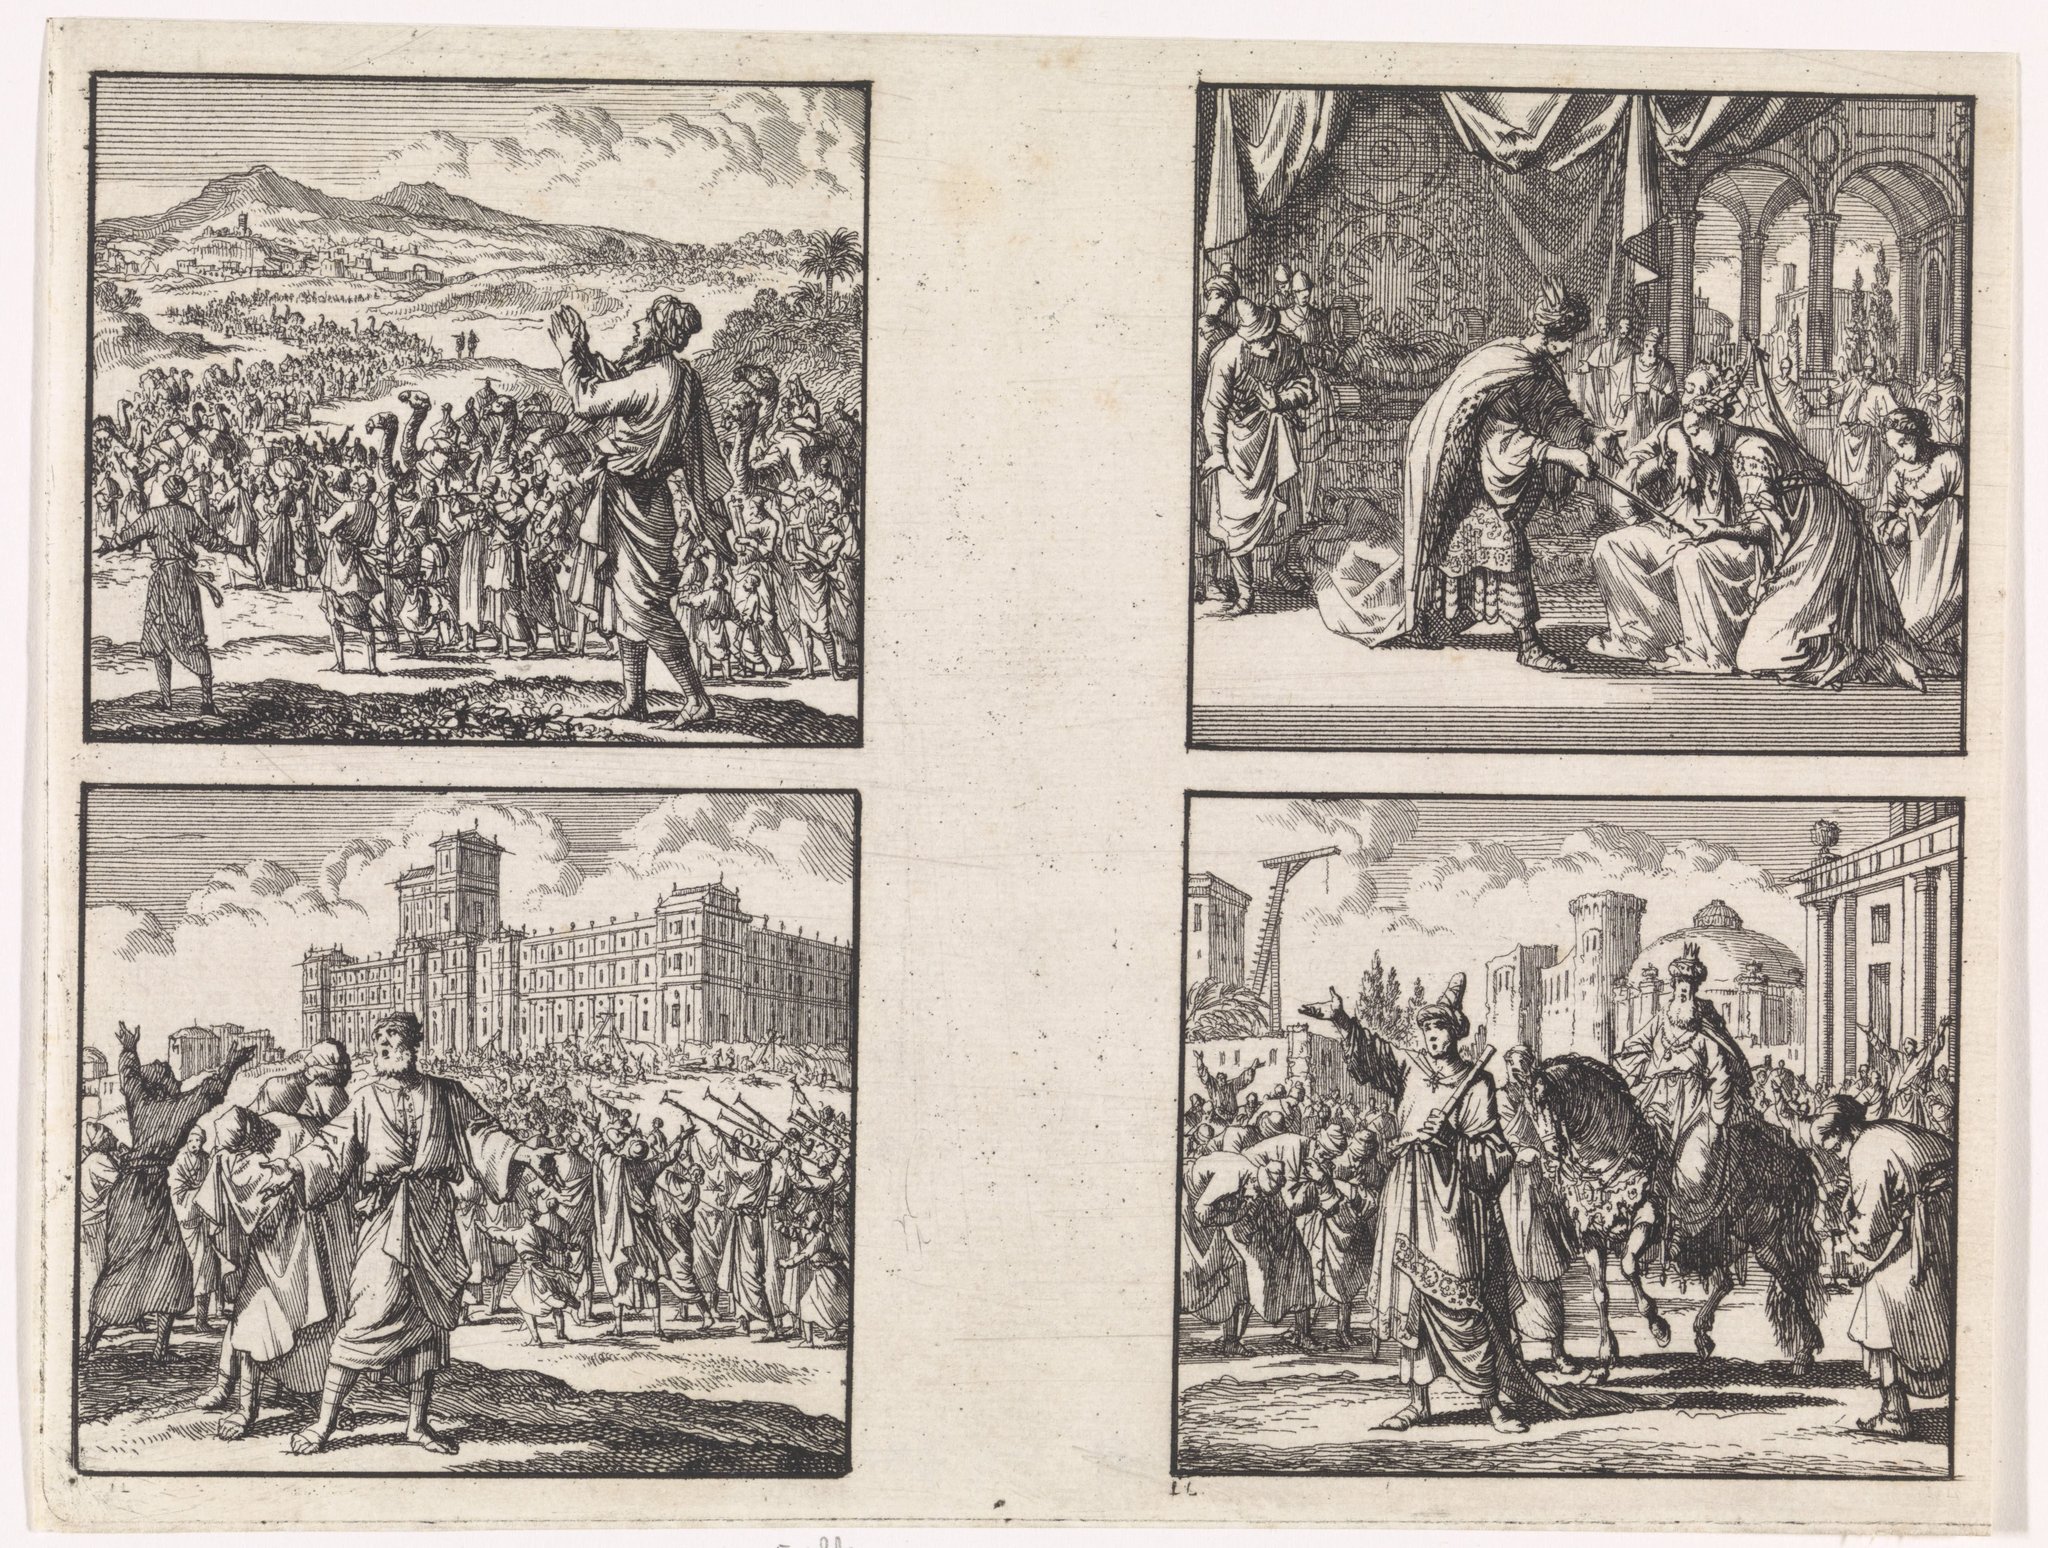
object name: print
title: Terugkeer uit de Babylonische ballingschap / Nieuwe tempel te Jeruzalem / Esther voor Ahasveros / Triomf van Mordechai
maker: jan luyken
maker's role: draughtsman, print maker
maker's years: 1649-1712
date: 1698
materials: paper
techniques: etching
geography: amsterdam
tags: the rebuilding of the temple (ezra 3), mordecai's triumph: mordecai, mounted on the king's horse, is led through the city by haman (esther and ahasuerus may be looking on from the palace), esther before ahasuerus (esther 5:1-4), return from the babylonian captivity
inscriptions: collector's mark: Lugt 2228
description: Proefdruk van illustraties uit: Josephus, Flavius. XX. boeken van de oude geschiedenissen der joden, 4 delen. Amsterdam: Barent Visscher, Willem de Coup, Willem van Lamsveld, Andries van Damme, 1698, dl. II.